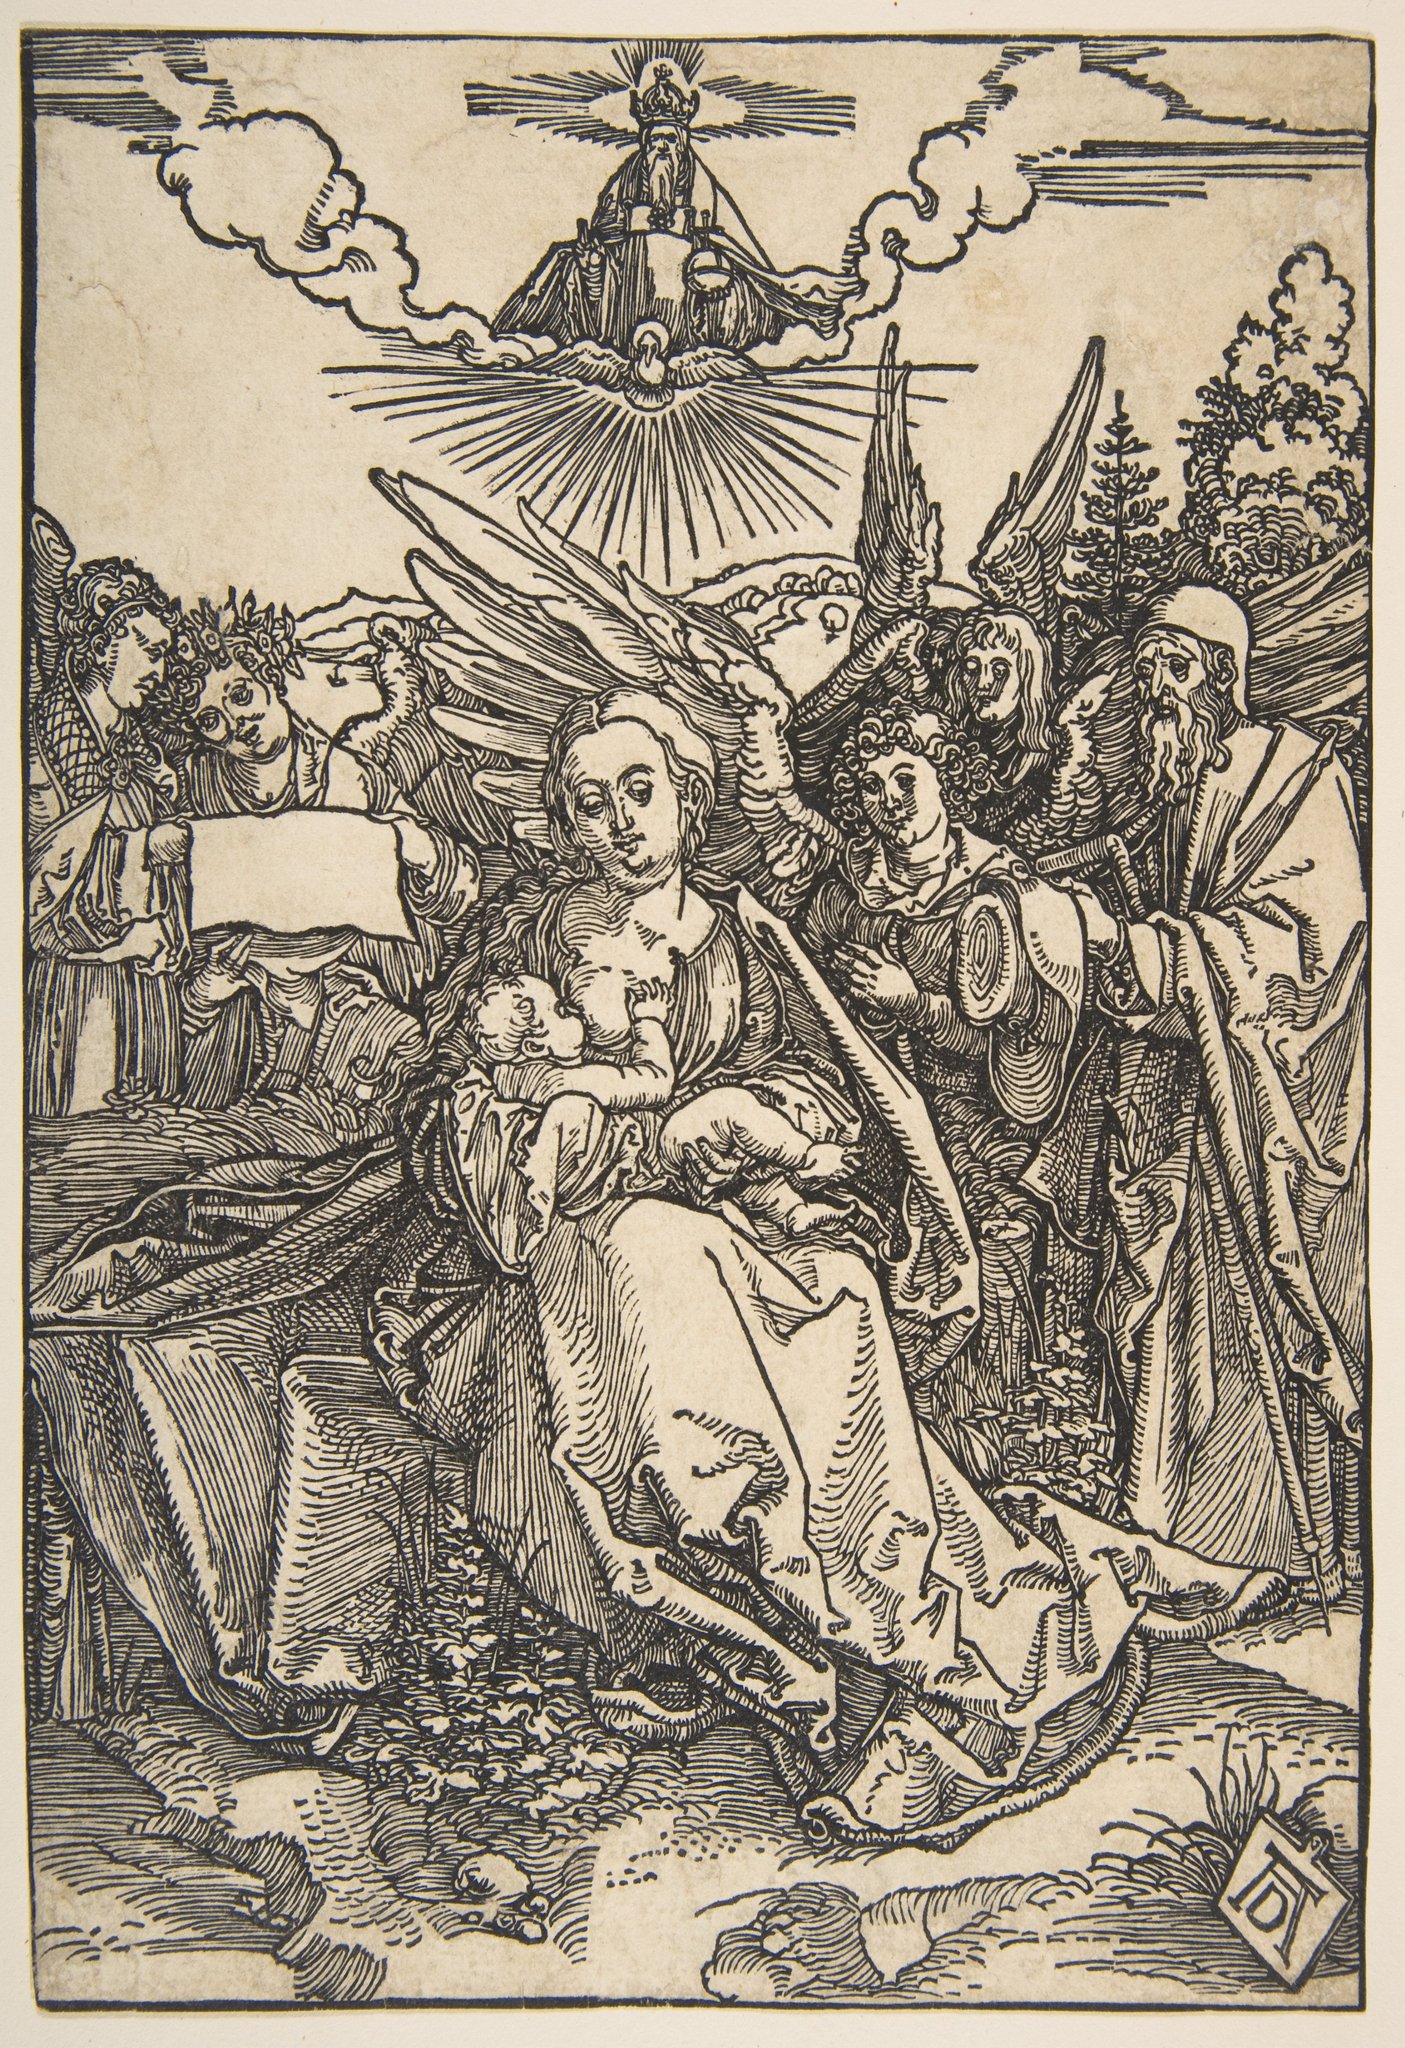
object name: print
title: The Holy Family with Five Angels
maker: albrecht dürer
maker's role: artist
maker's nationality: german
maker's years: 1471-1528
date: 1503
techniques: woodcut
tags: angels,christ,holy family,saint joseph,virgin mary